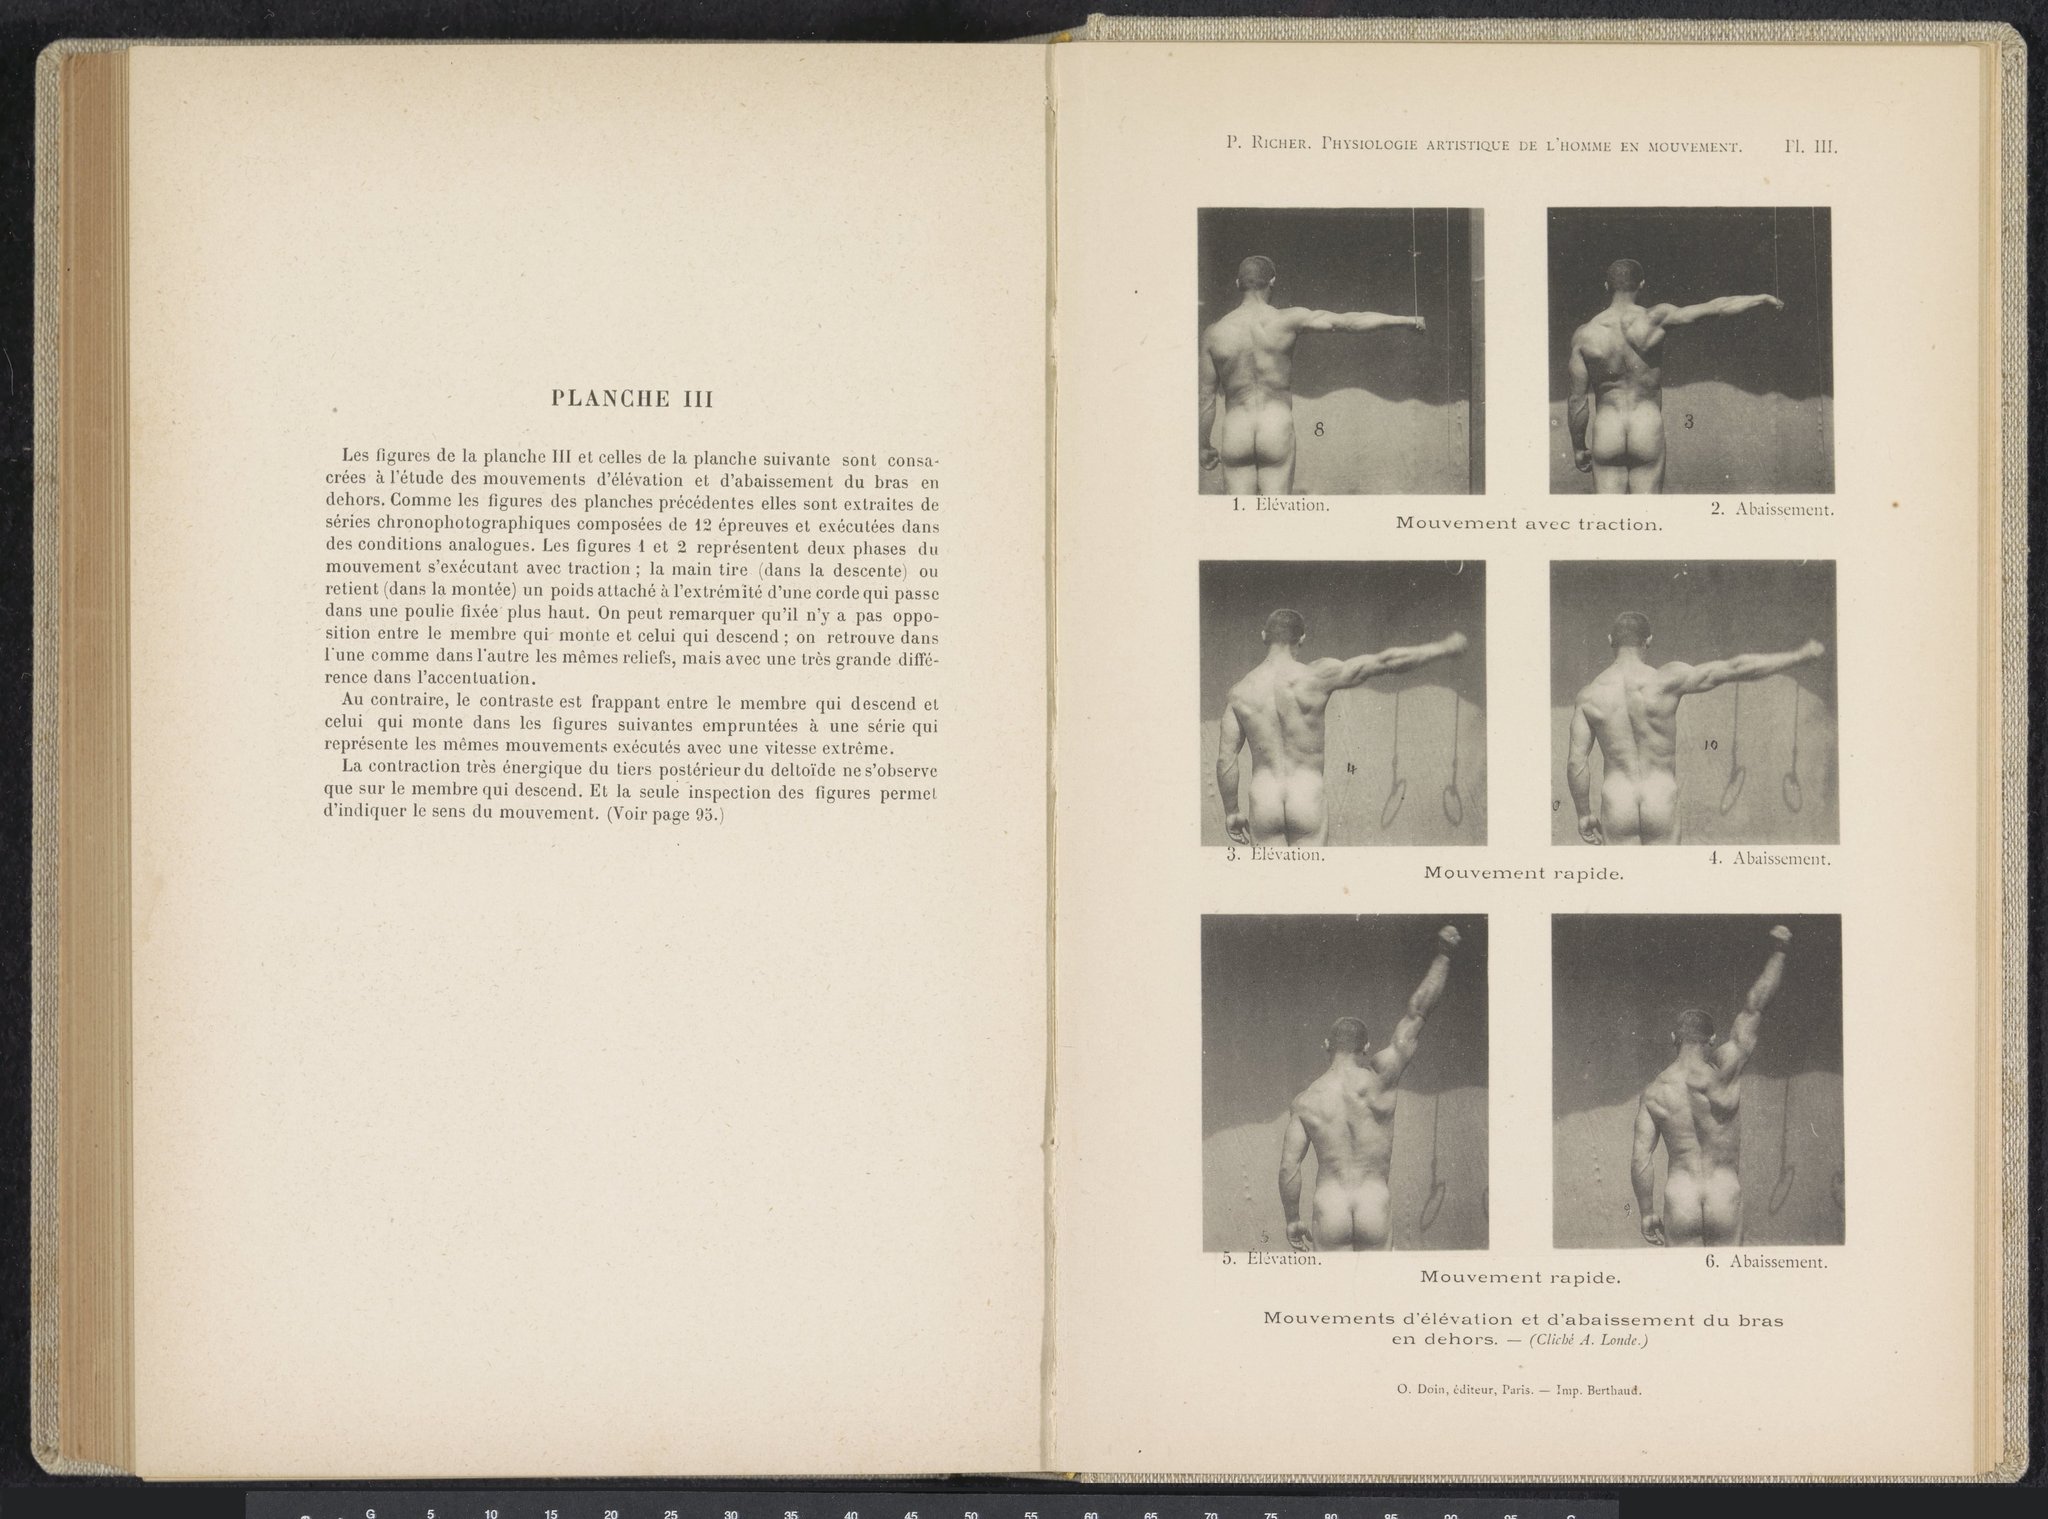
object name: photomechanical print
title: Mouvements d'élévation et d'abaissement du bras en dehors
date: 1885-1895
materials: paper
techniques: photograph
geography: france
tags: movements of the human body, anatomy (non-medical), arm stretched sidewards, man (showing himself) undressed, quasi-nude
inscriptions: number: ‘8, 3, 4, 10, 5, 9’, number: ‘1. (...) 6.’, inscription: ‘Élévation. (...) Abaissement.’, number: ‘Pl. III.’